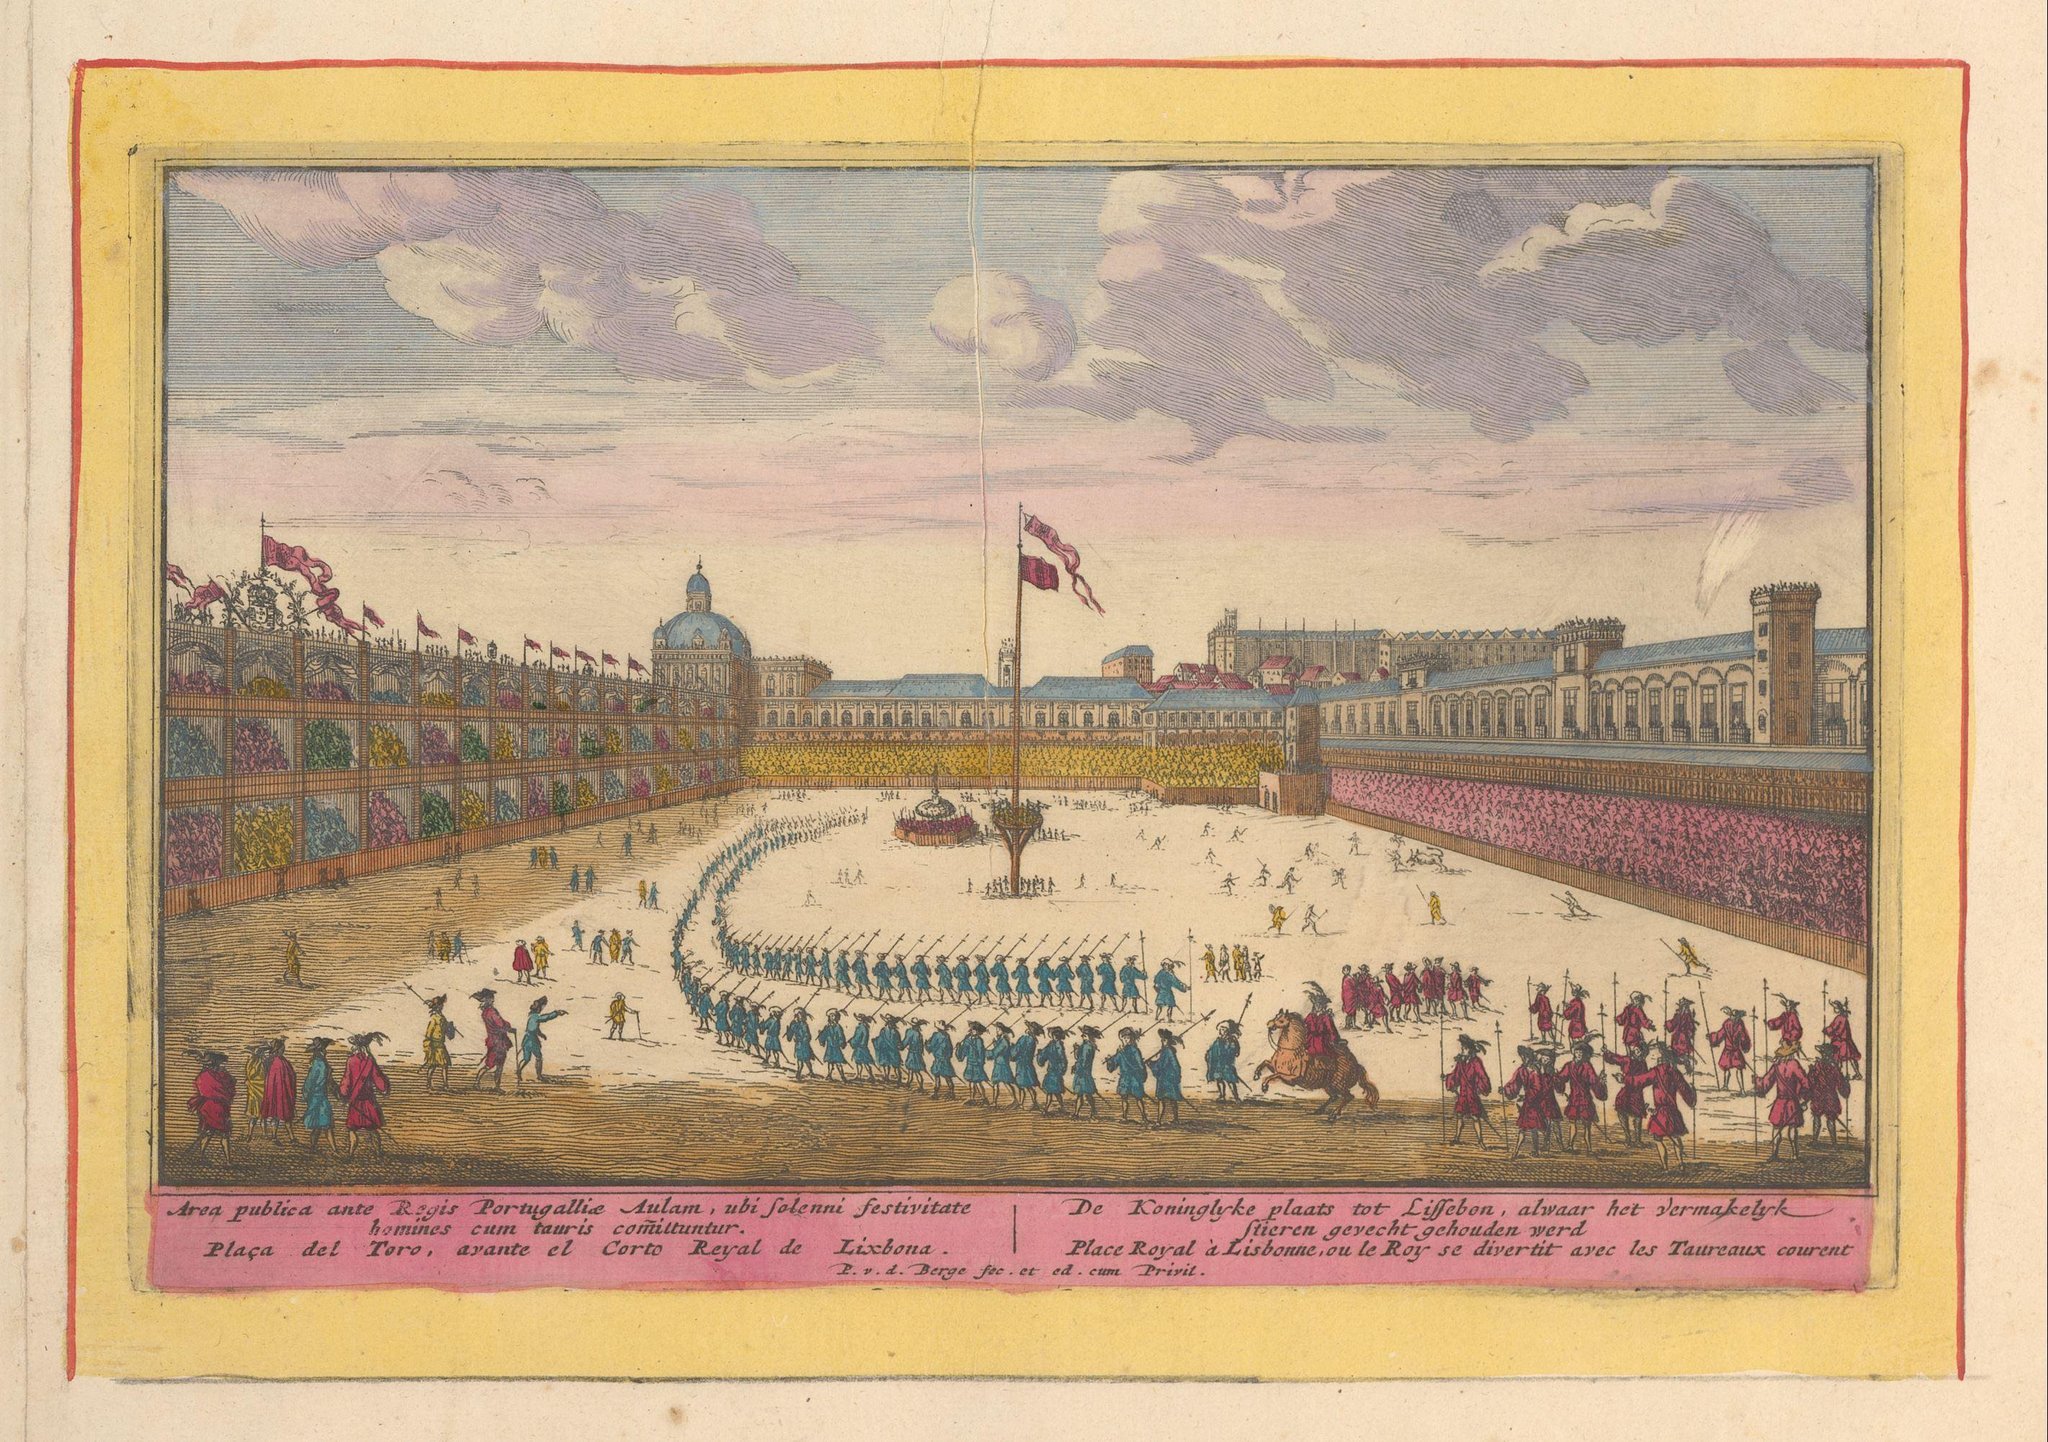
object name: book illustration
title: Theatrum Hispaniae (...)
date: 1694-1737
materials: paper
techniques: etching, hand coloring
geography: the hague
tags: village square, place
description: Prent uit: Theatrum Hispaniæ, exhibens regni urbes, villas ac viridaria magis illustria. Het aanmerkelykste en voortreffelykste in Spanjen (...). Amsterdam: Pieter van den Berge, ca. 1694-1737.